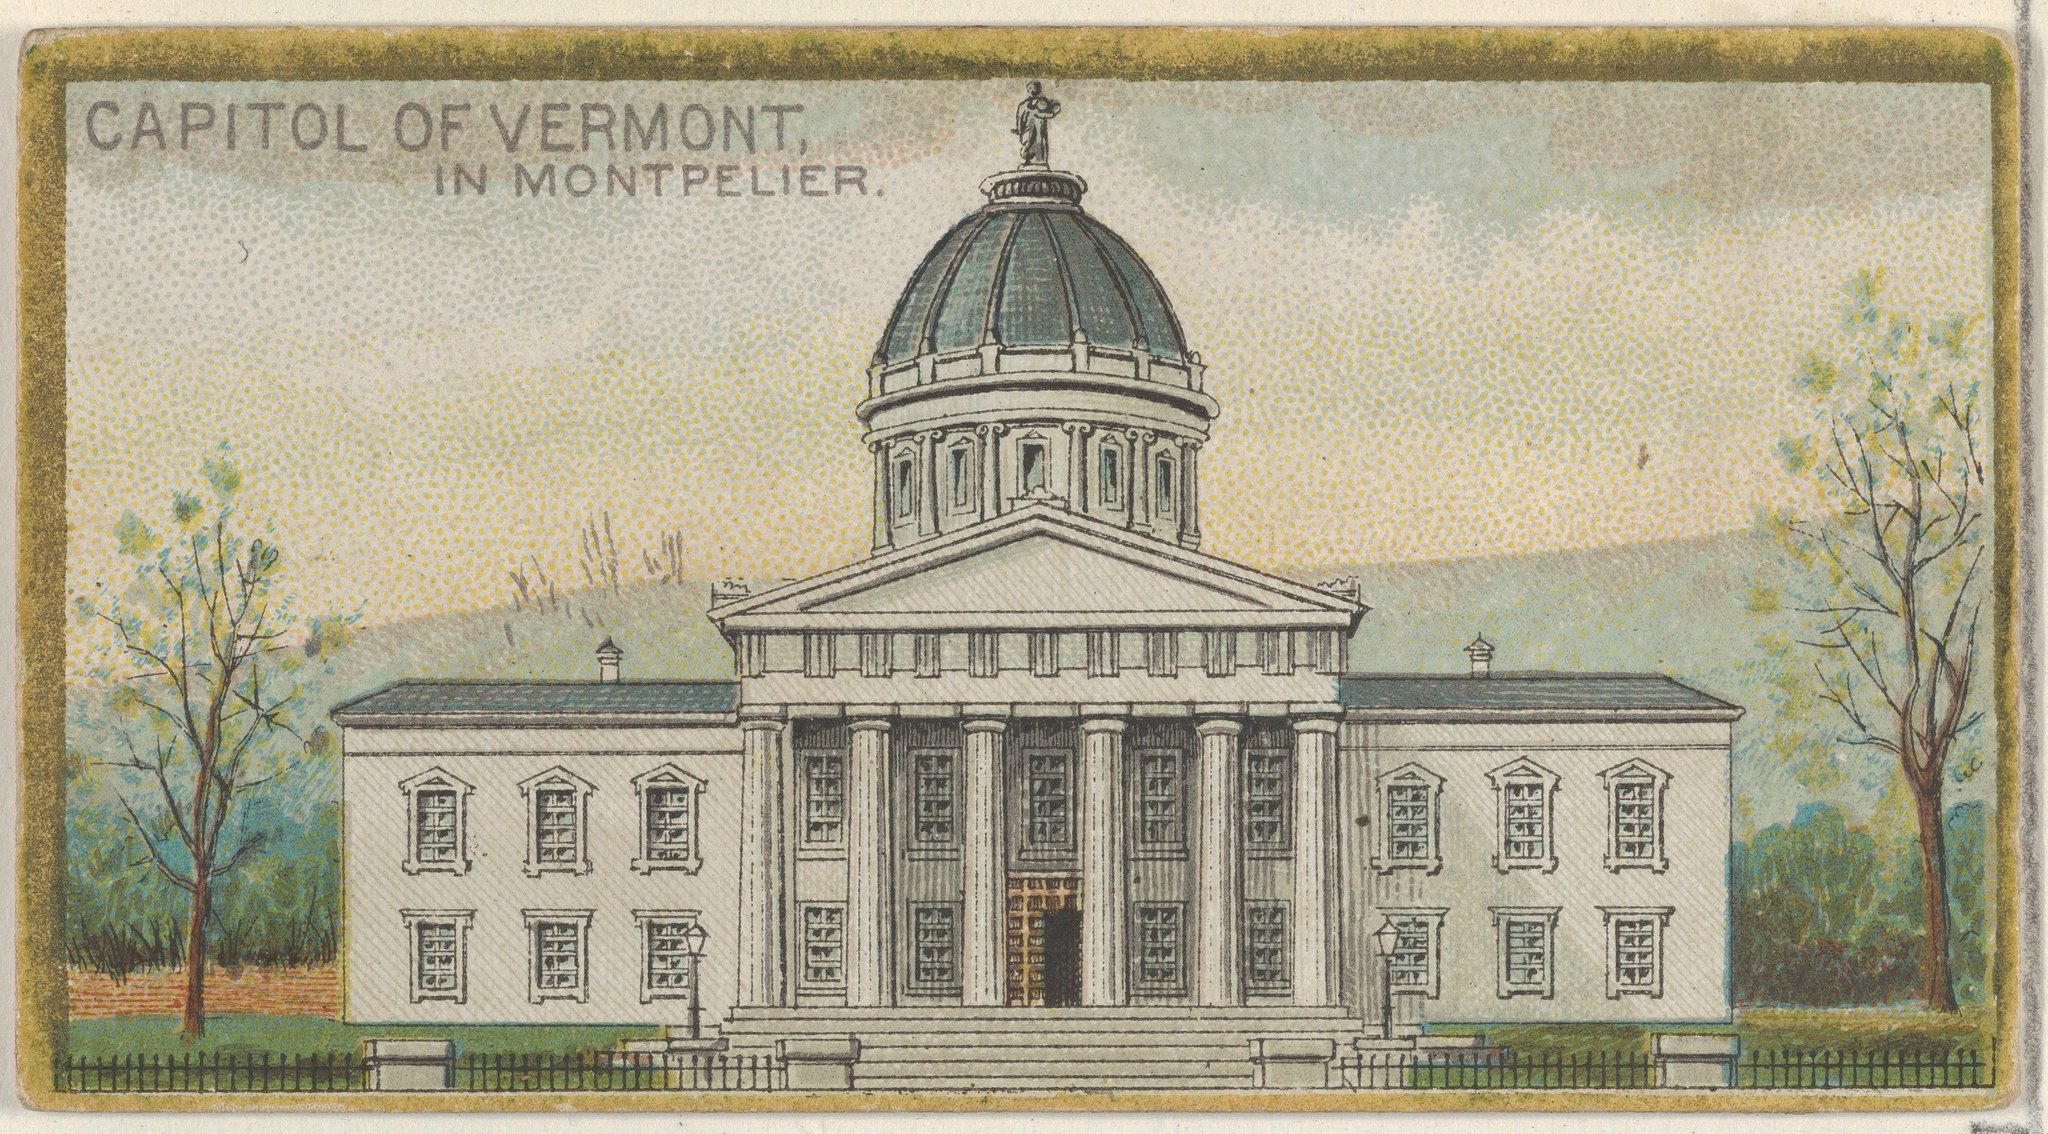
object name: print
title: Capitol of Vermont in Montpelier, from the General Government and State Capitol Buildings series (N14) for Allen & Ginter Cigarettes Brands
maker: allen & ginter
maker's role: publisher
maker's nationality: american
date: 1889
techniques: color lithograph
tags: buildings